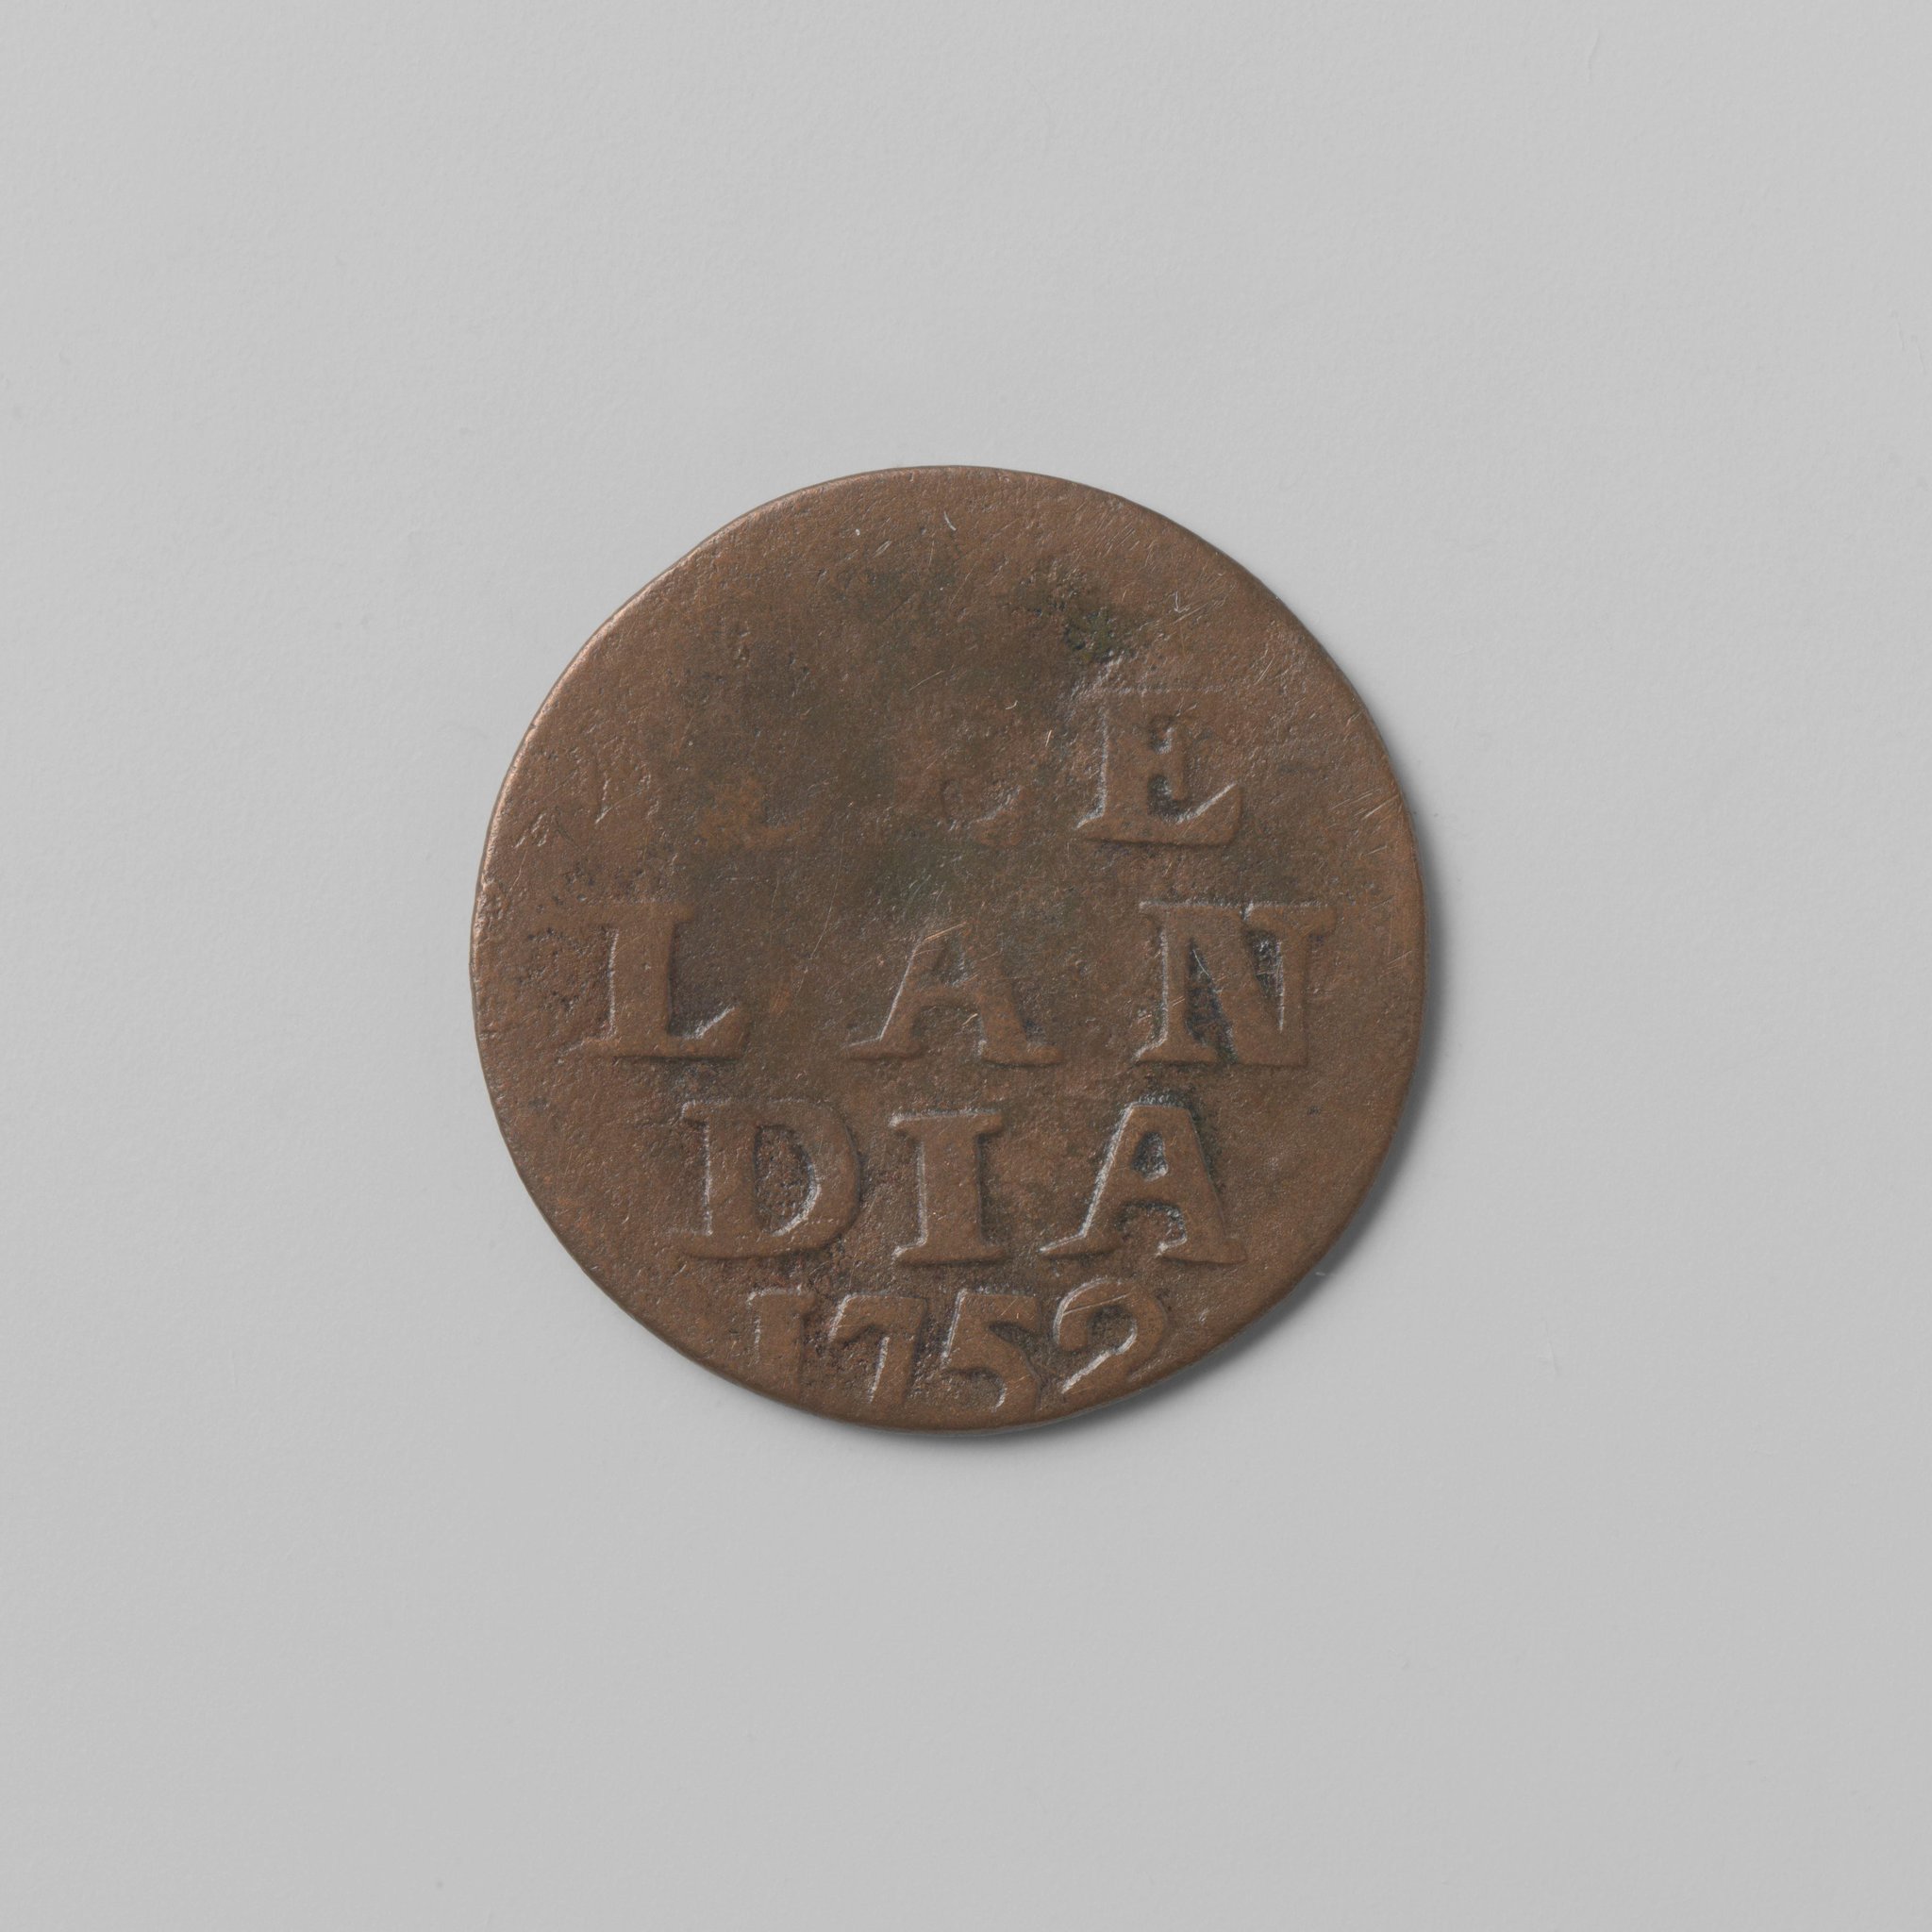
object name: coin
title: Zeeuwse duit, 1752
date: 1752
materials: copper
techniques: striking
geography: middelburg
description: Koperen munt. Voorzijde: gekroond, zijdelings ingedeukt wapenschild van Zeeland. Keerzijde: opschrift in drie regels, waarboven muntteken burcht tussen twee sterren en waaronder jaartal.